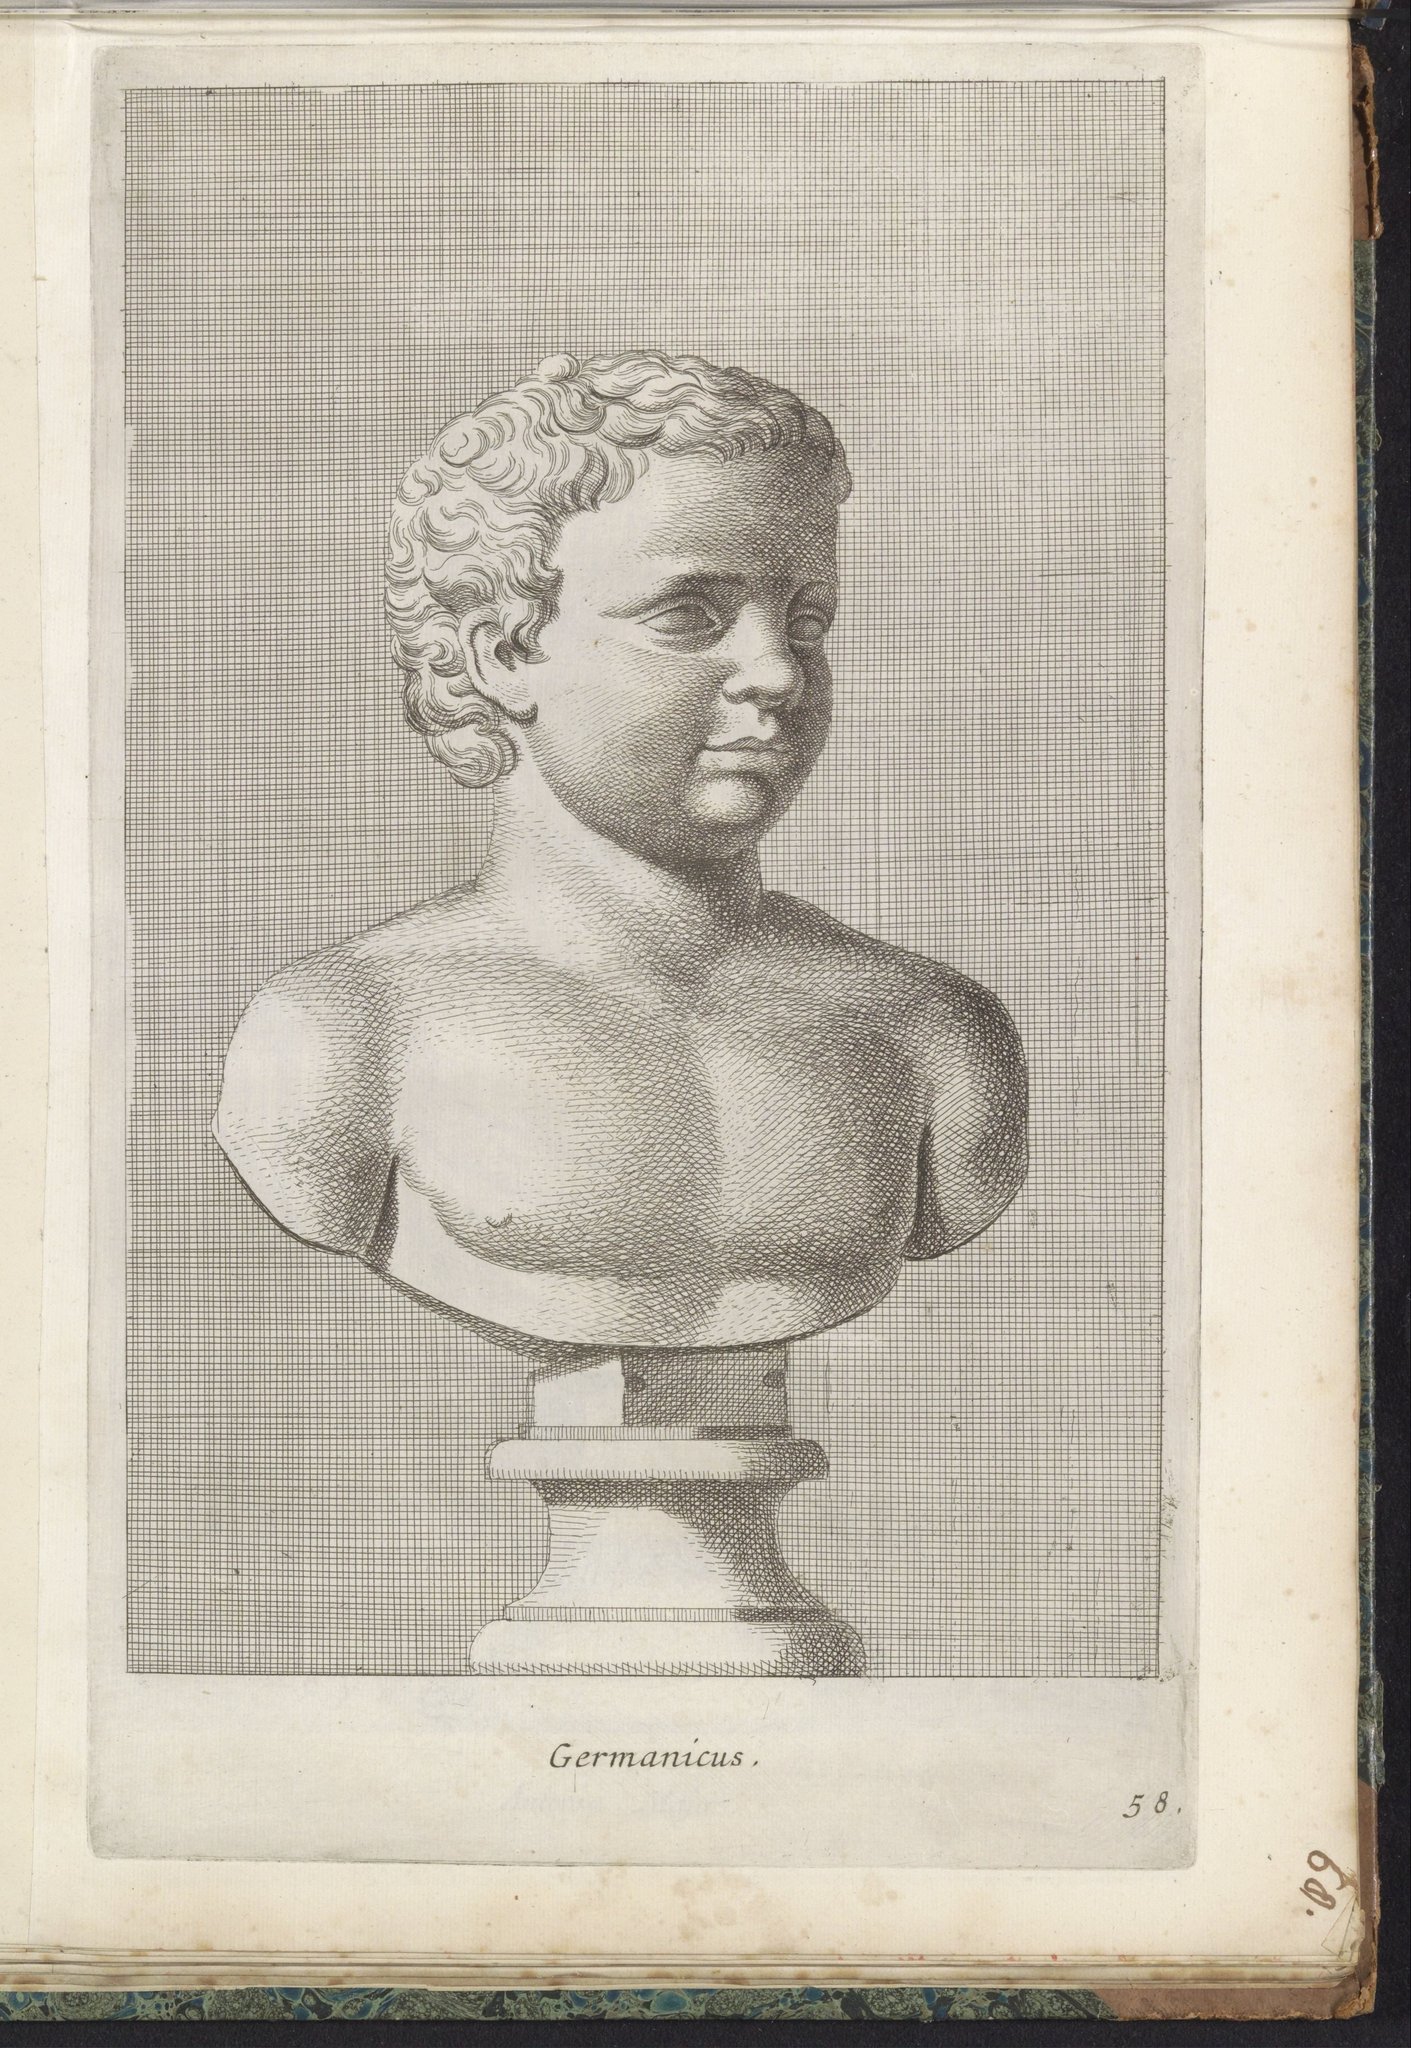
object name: print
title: Germanicus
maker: hubert quellinus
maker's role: print maker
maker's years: 1619-1687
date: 1646-1670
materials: paper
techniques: engraving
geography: antwerp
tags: piece of sculpture, reproduction of a piece of sculpture, male persons from classical history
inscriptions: number: ‘68’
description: Klassieke buste van een jongen met ontbloot bovenlichaam, naar rechts gedraaid. De prent maakt deel uit van een album met een serie prenten naar de sculpturen in de verzameling van Gerard Reynst.